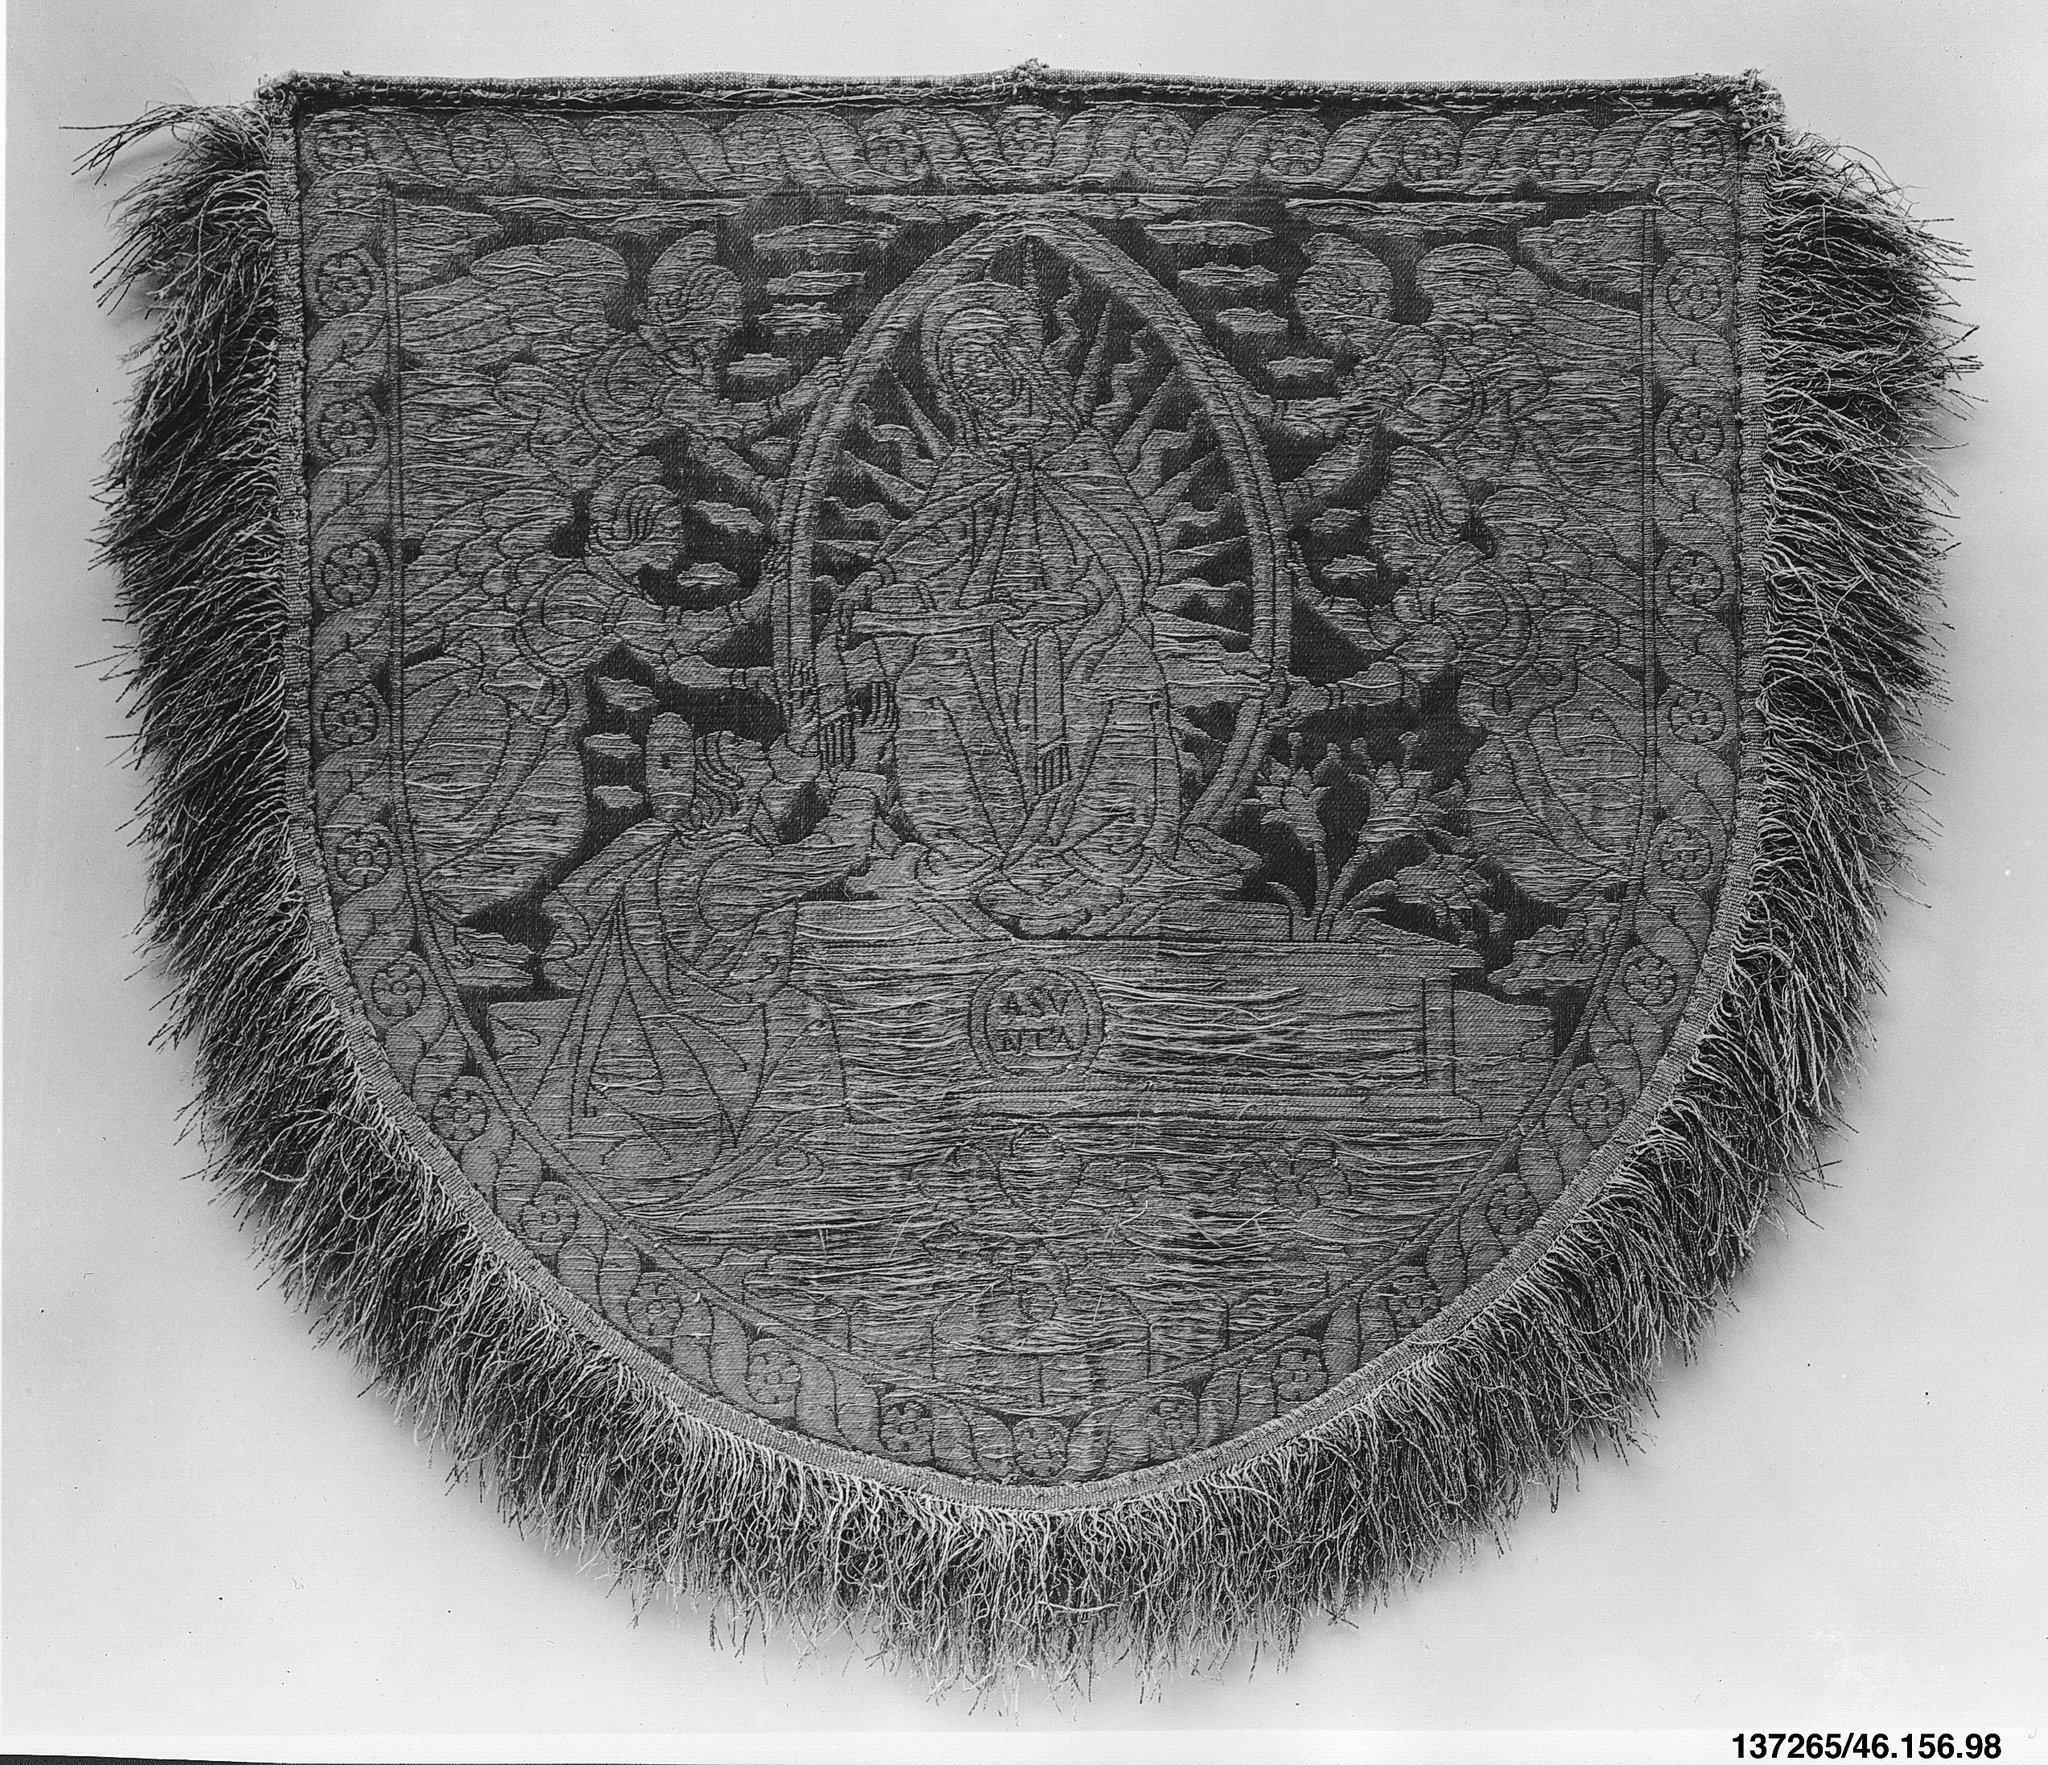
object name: hood from a cope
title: Hood for a cope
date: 1467-1533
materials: linen, metal thread, silk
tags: angels,virgin mary